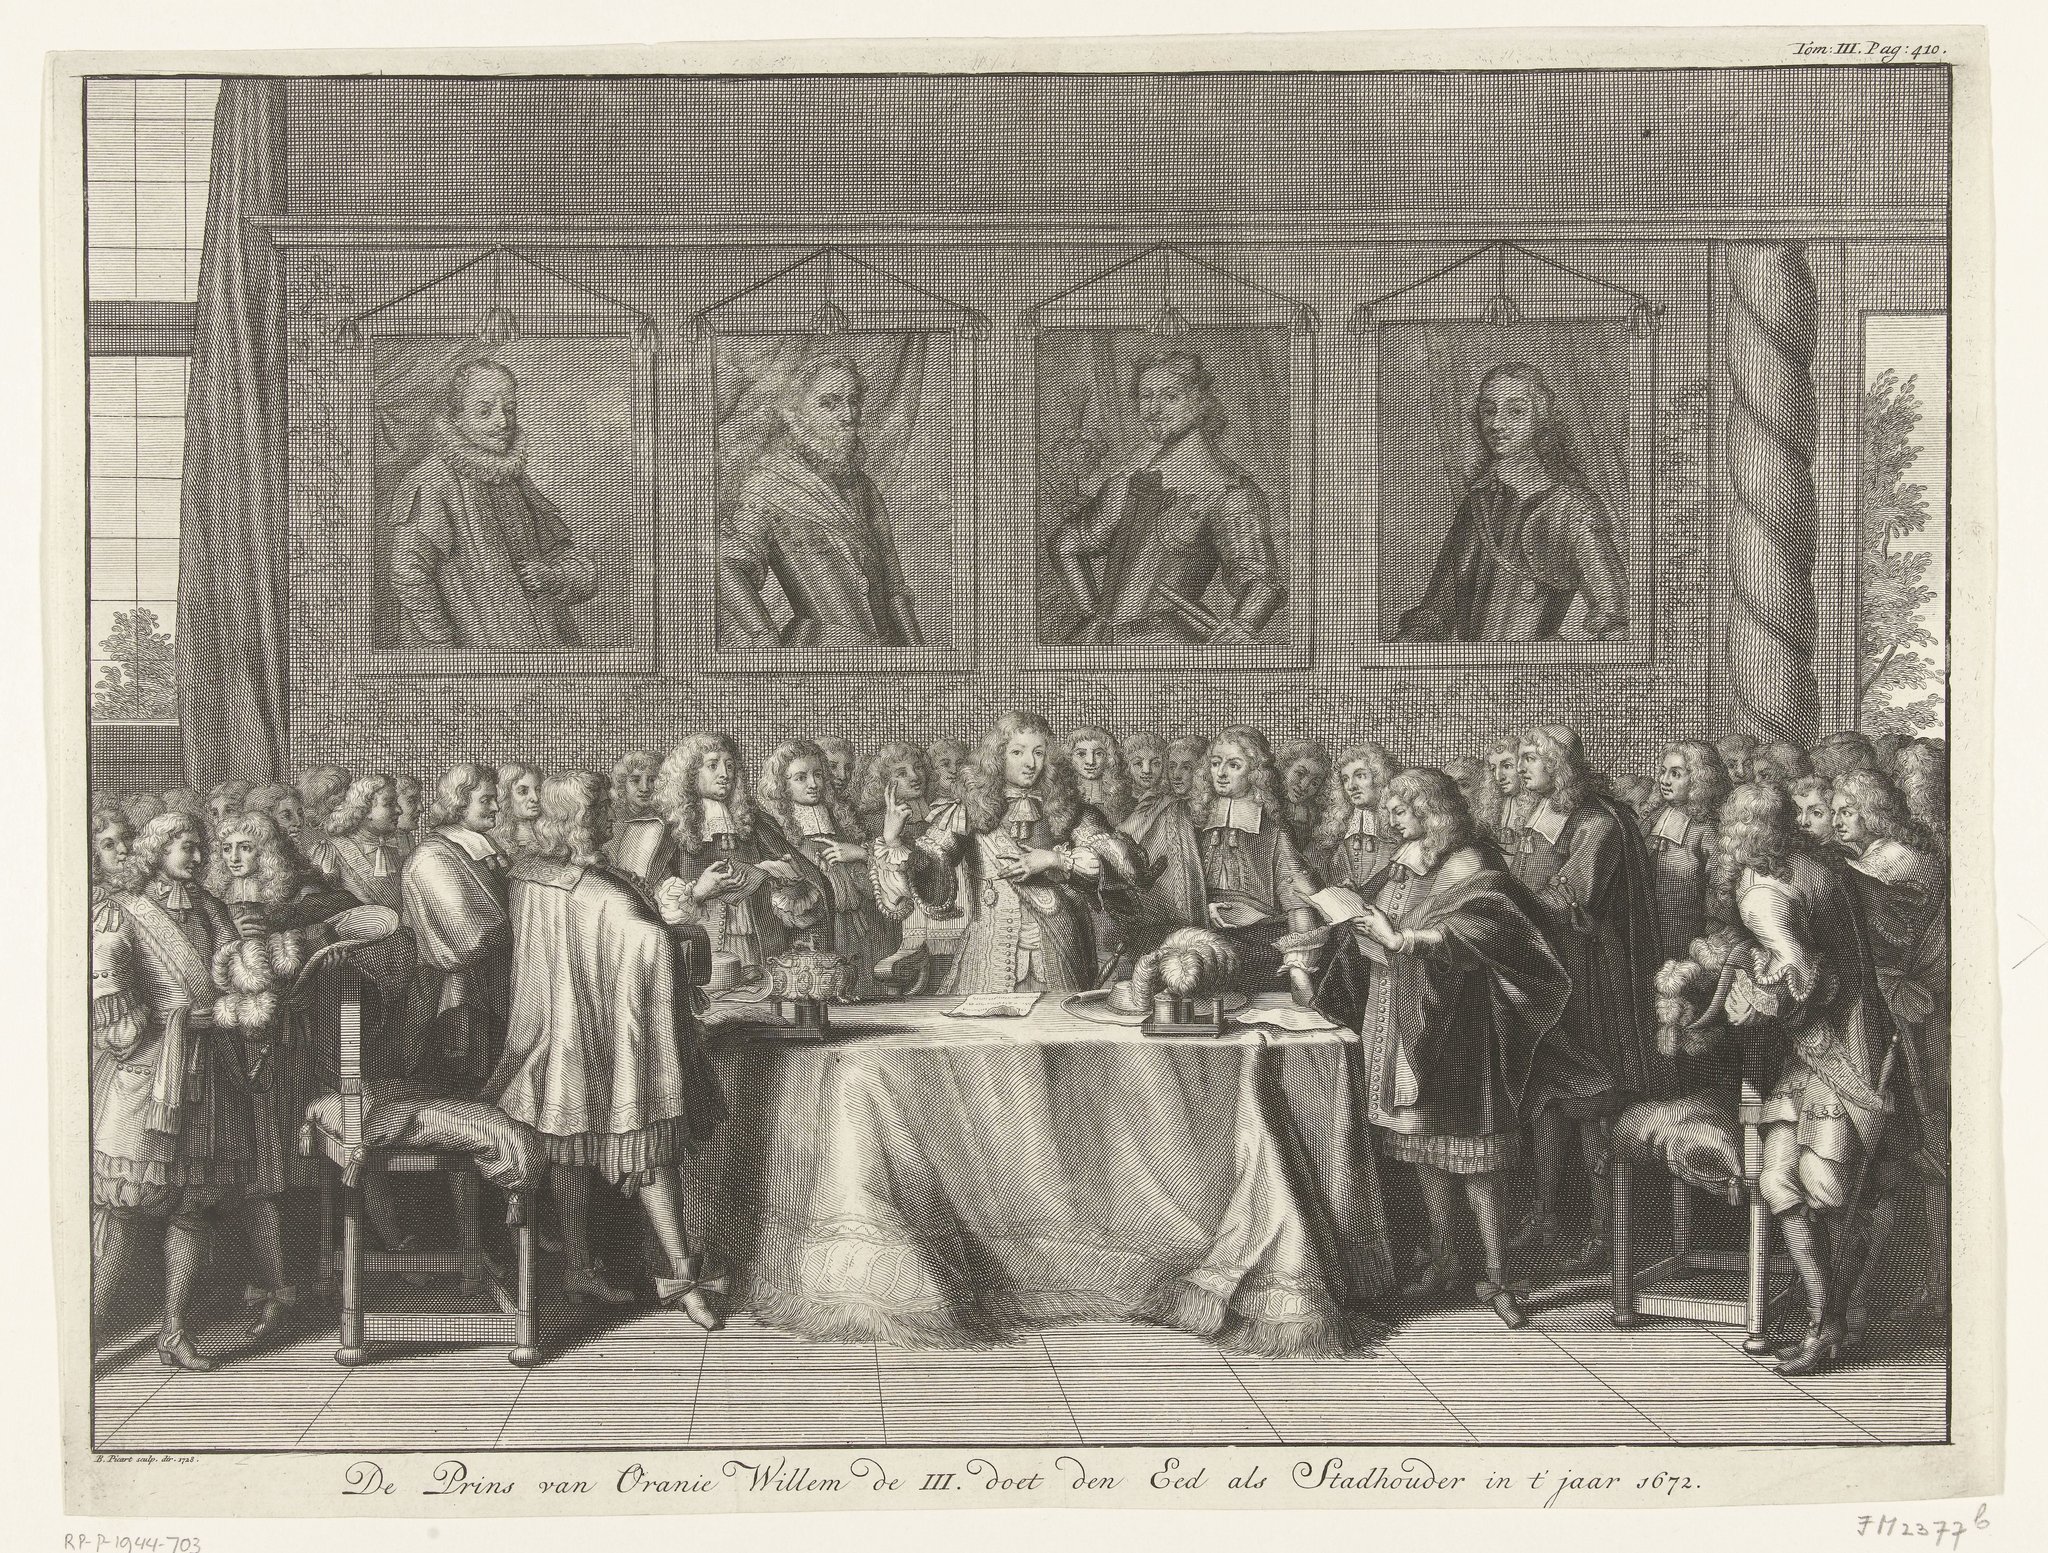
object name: print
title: De Prins van Oranie Willem de III. doet den Eed als Stadhouder in 't jaar 1672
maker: bernard picart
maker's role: draughtsman, print maker, publisher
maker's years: 1673-1733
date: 1728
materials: paper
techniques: engraving, etching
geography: northern netherlands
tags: william iii (prince of orange and king of england, scotland, and ireland), frederick henry (prince of orange), william ii (prince of orange), william i (prince of orange), the hague, maurice (prince of orange), new ruler taking the oath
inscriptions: date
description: Gebruikt als illustratie in: J. le Clerc, Geschiedenissen der Vereenigde Nederlanden, sedert den aanvang van die Republyk tot op den Vrede van Utrecht in 't jaar 1713 en het Tractaat van Barriere in 't jaar 1715 gesloten, Z. Chatelain, Amsterdam 1730, 3 delen, dl. III, p. 410.